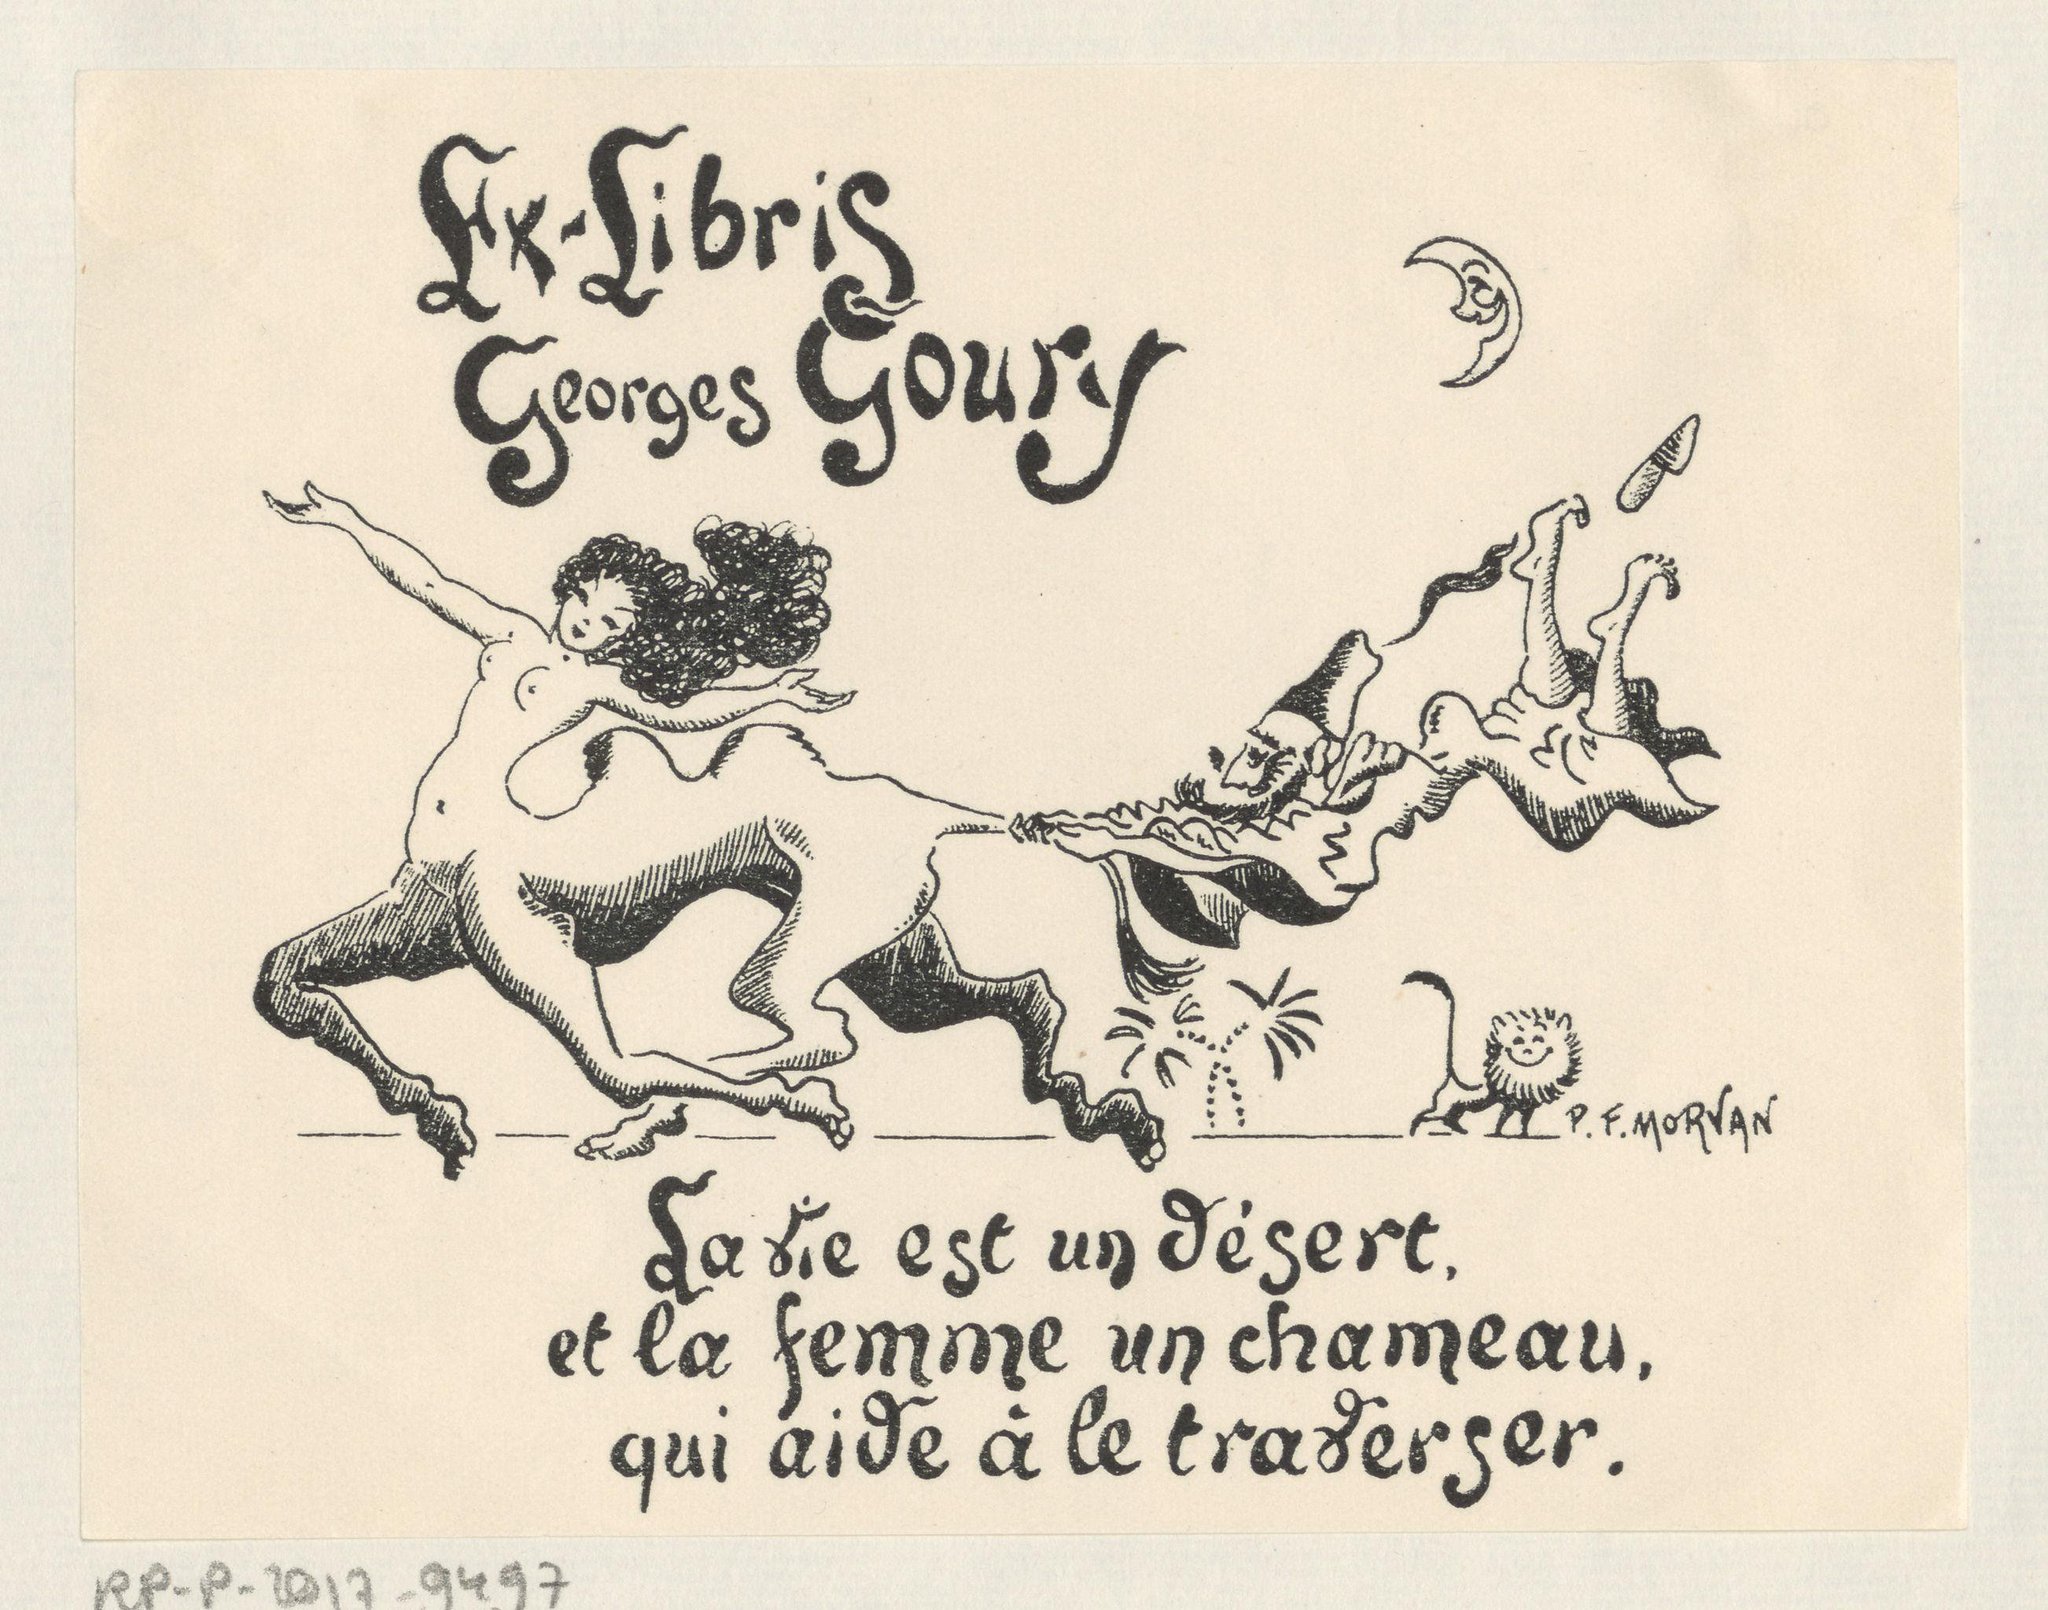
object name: bookplate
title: La vie est un désert (...) à le traverser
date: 1900-1959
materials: paper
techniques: printing block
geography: france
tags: hoofed animals: camel, woman (showing herself) undressed, quasi-nude